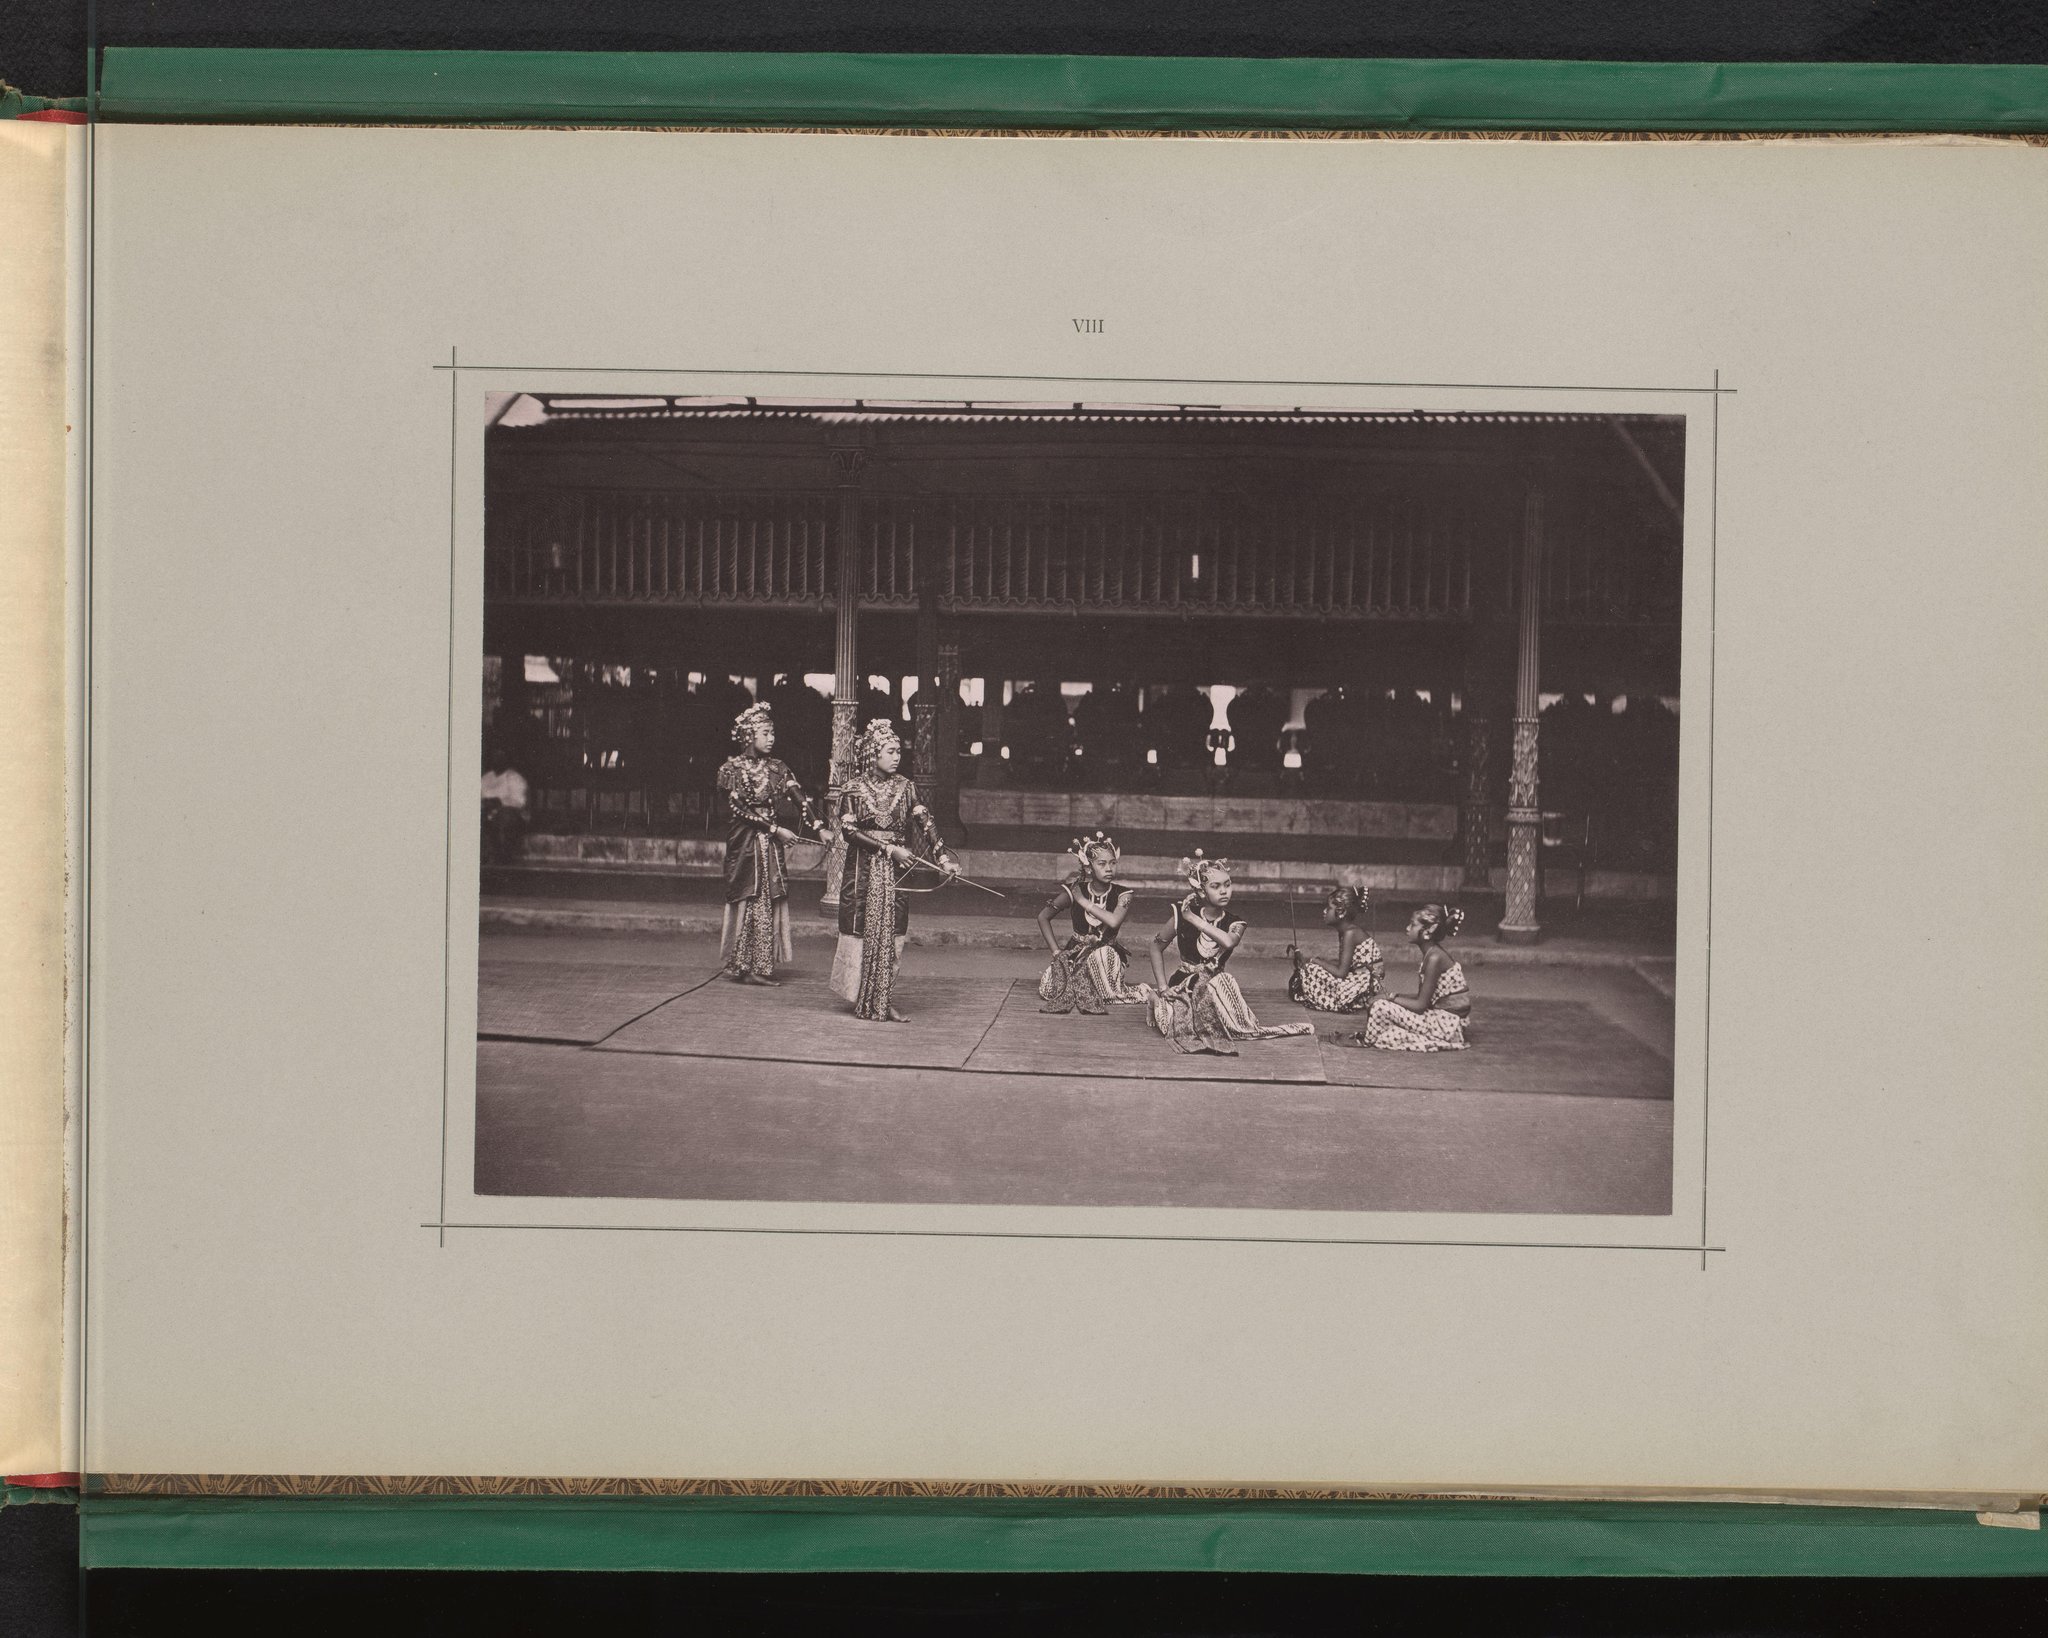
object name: photomechanical print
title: Zes jonge vrouwen voeren een toneelstuk op in de Kraton Ngayogyakarta Hadiningrat in Jogyakarta, Indonesië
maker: kassian céphas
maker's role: fotograaf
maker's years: 1845-1912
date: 1883-1888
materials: paper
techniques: photograph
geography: yogyakarta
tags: group of actors, troupe; actors on the stage, adolescent, young woman, maiden (+ six persons)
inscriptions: number: ‘VIII’